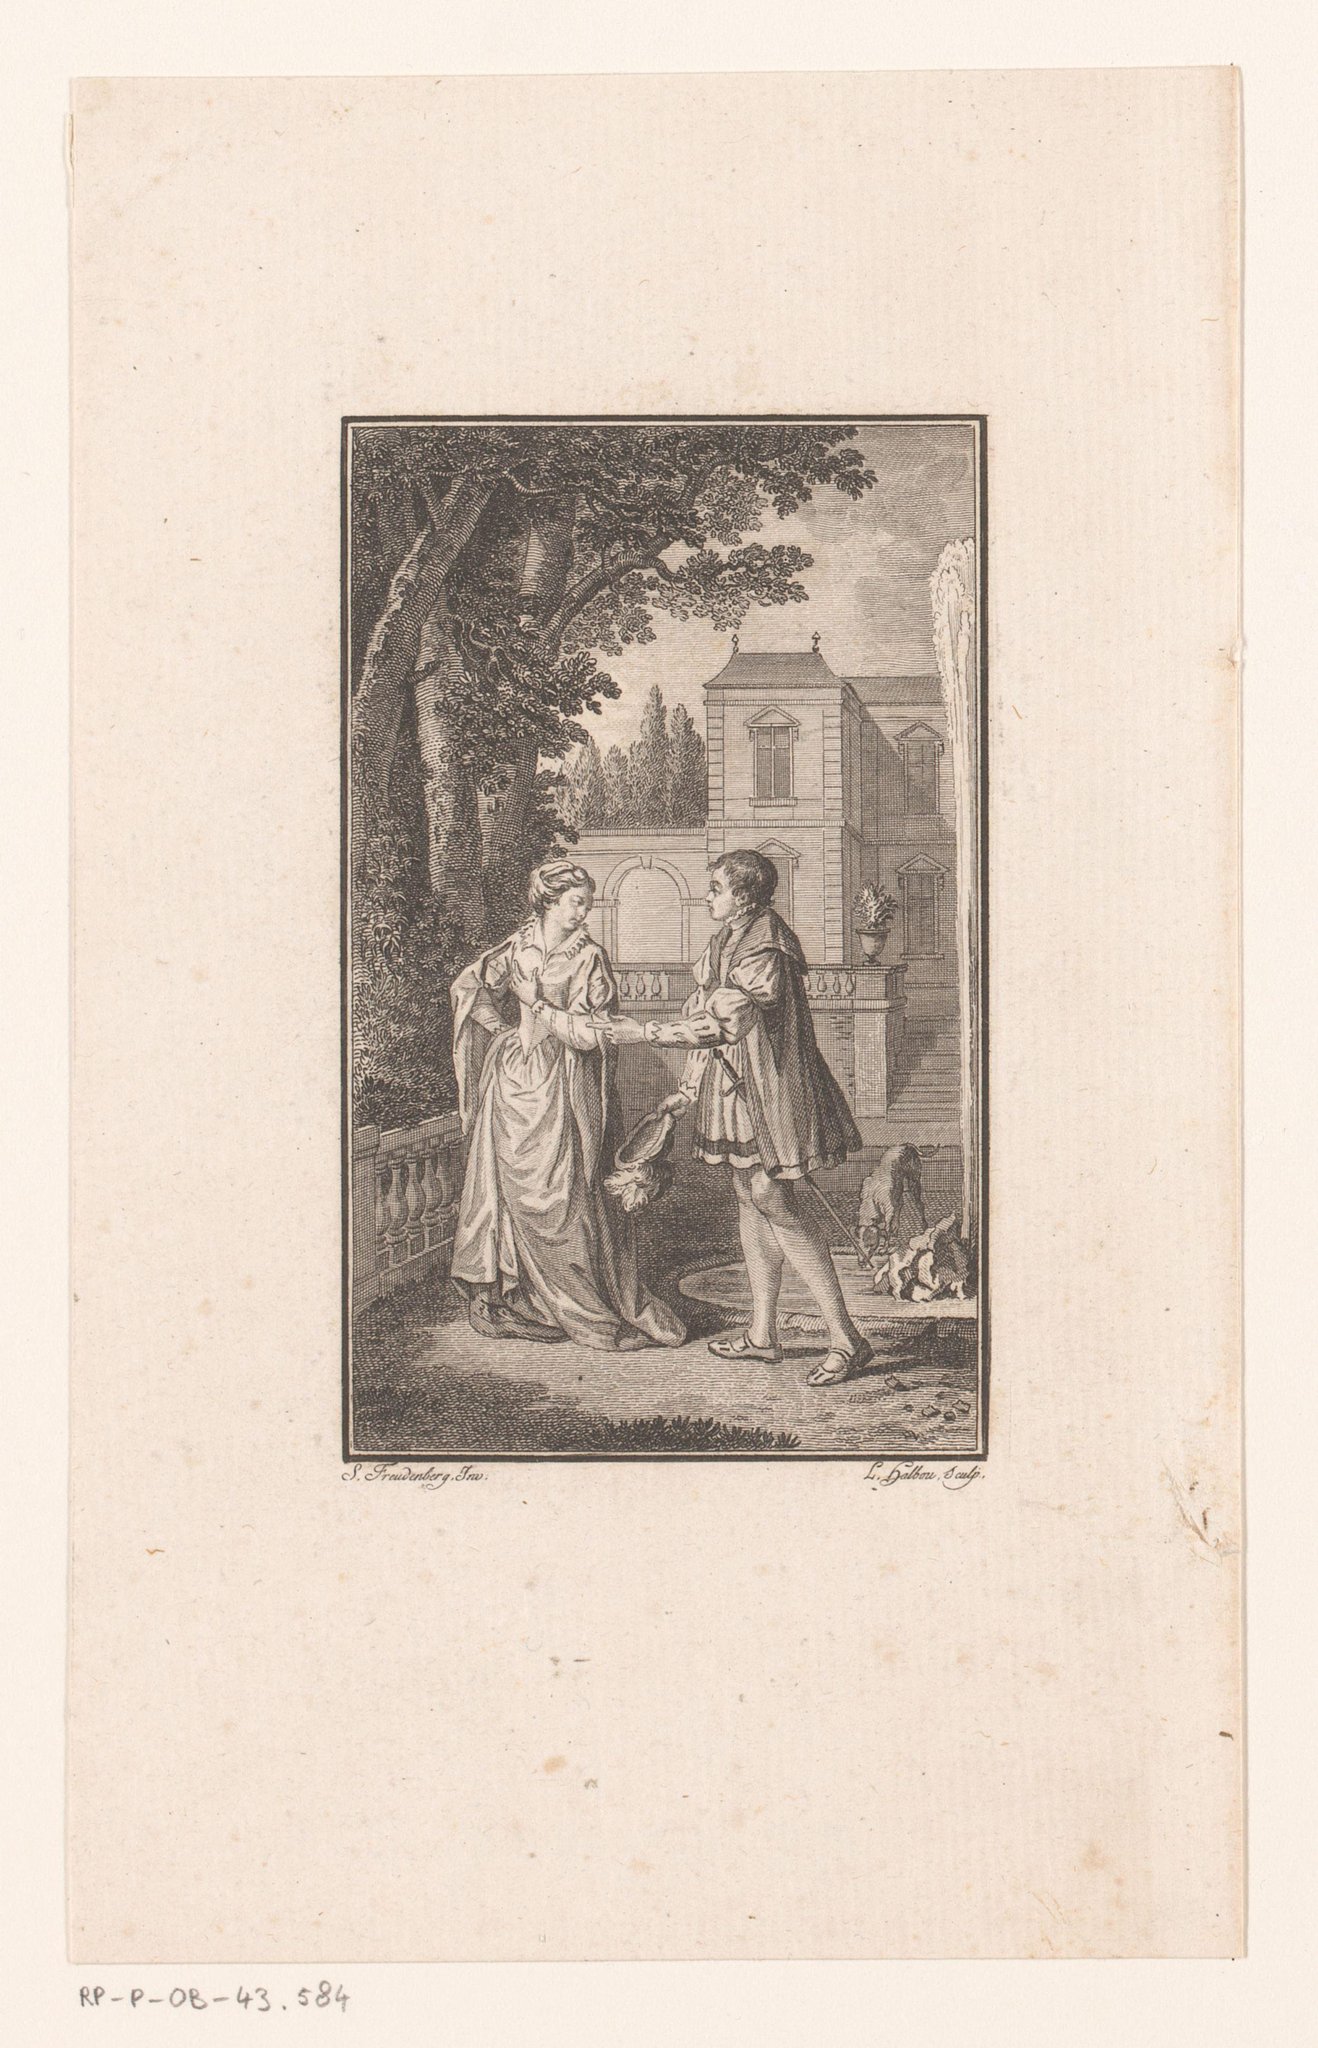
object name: print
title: Elegant paar in een tuin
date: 1781-1782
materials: paper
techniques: etching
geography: bern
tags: courting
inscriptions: collector's mark: Lugt 2228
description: Prent uit: Les Nouvelles de Marguerite, reine de Navarre. Bern: la nouvelle Société Typographique, 1780-1781.